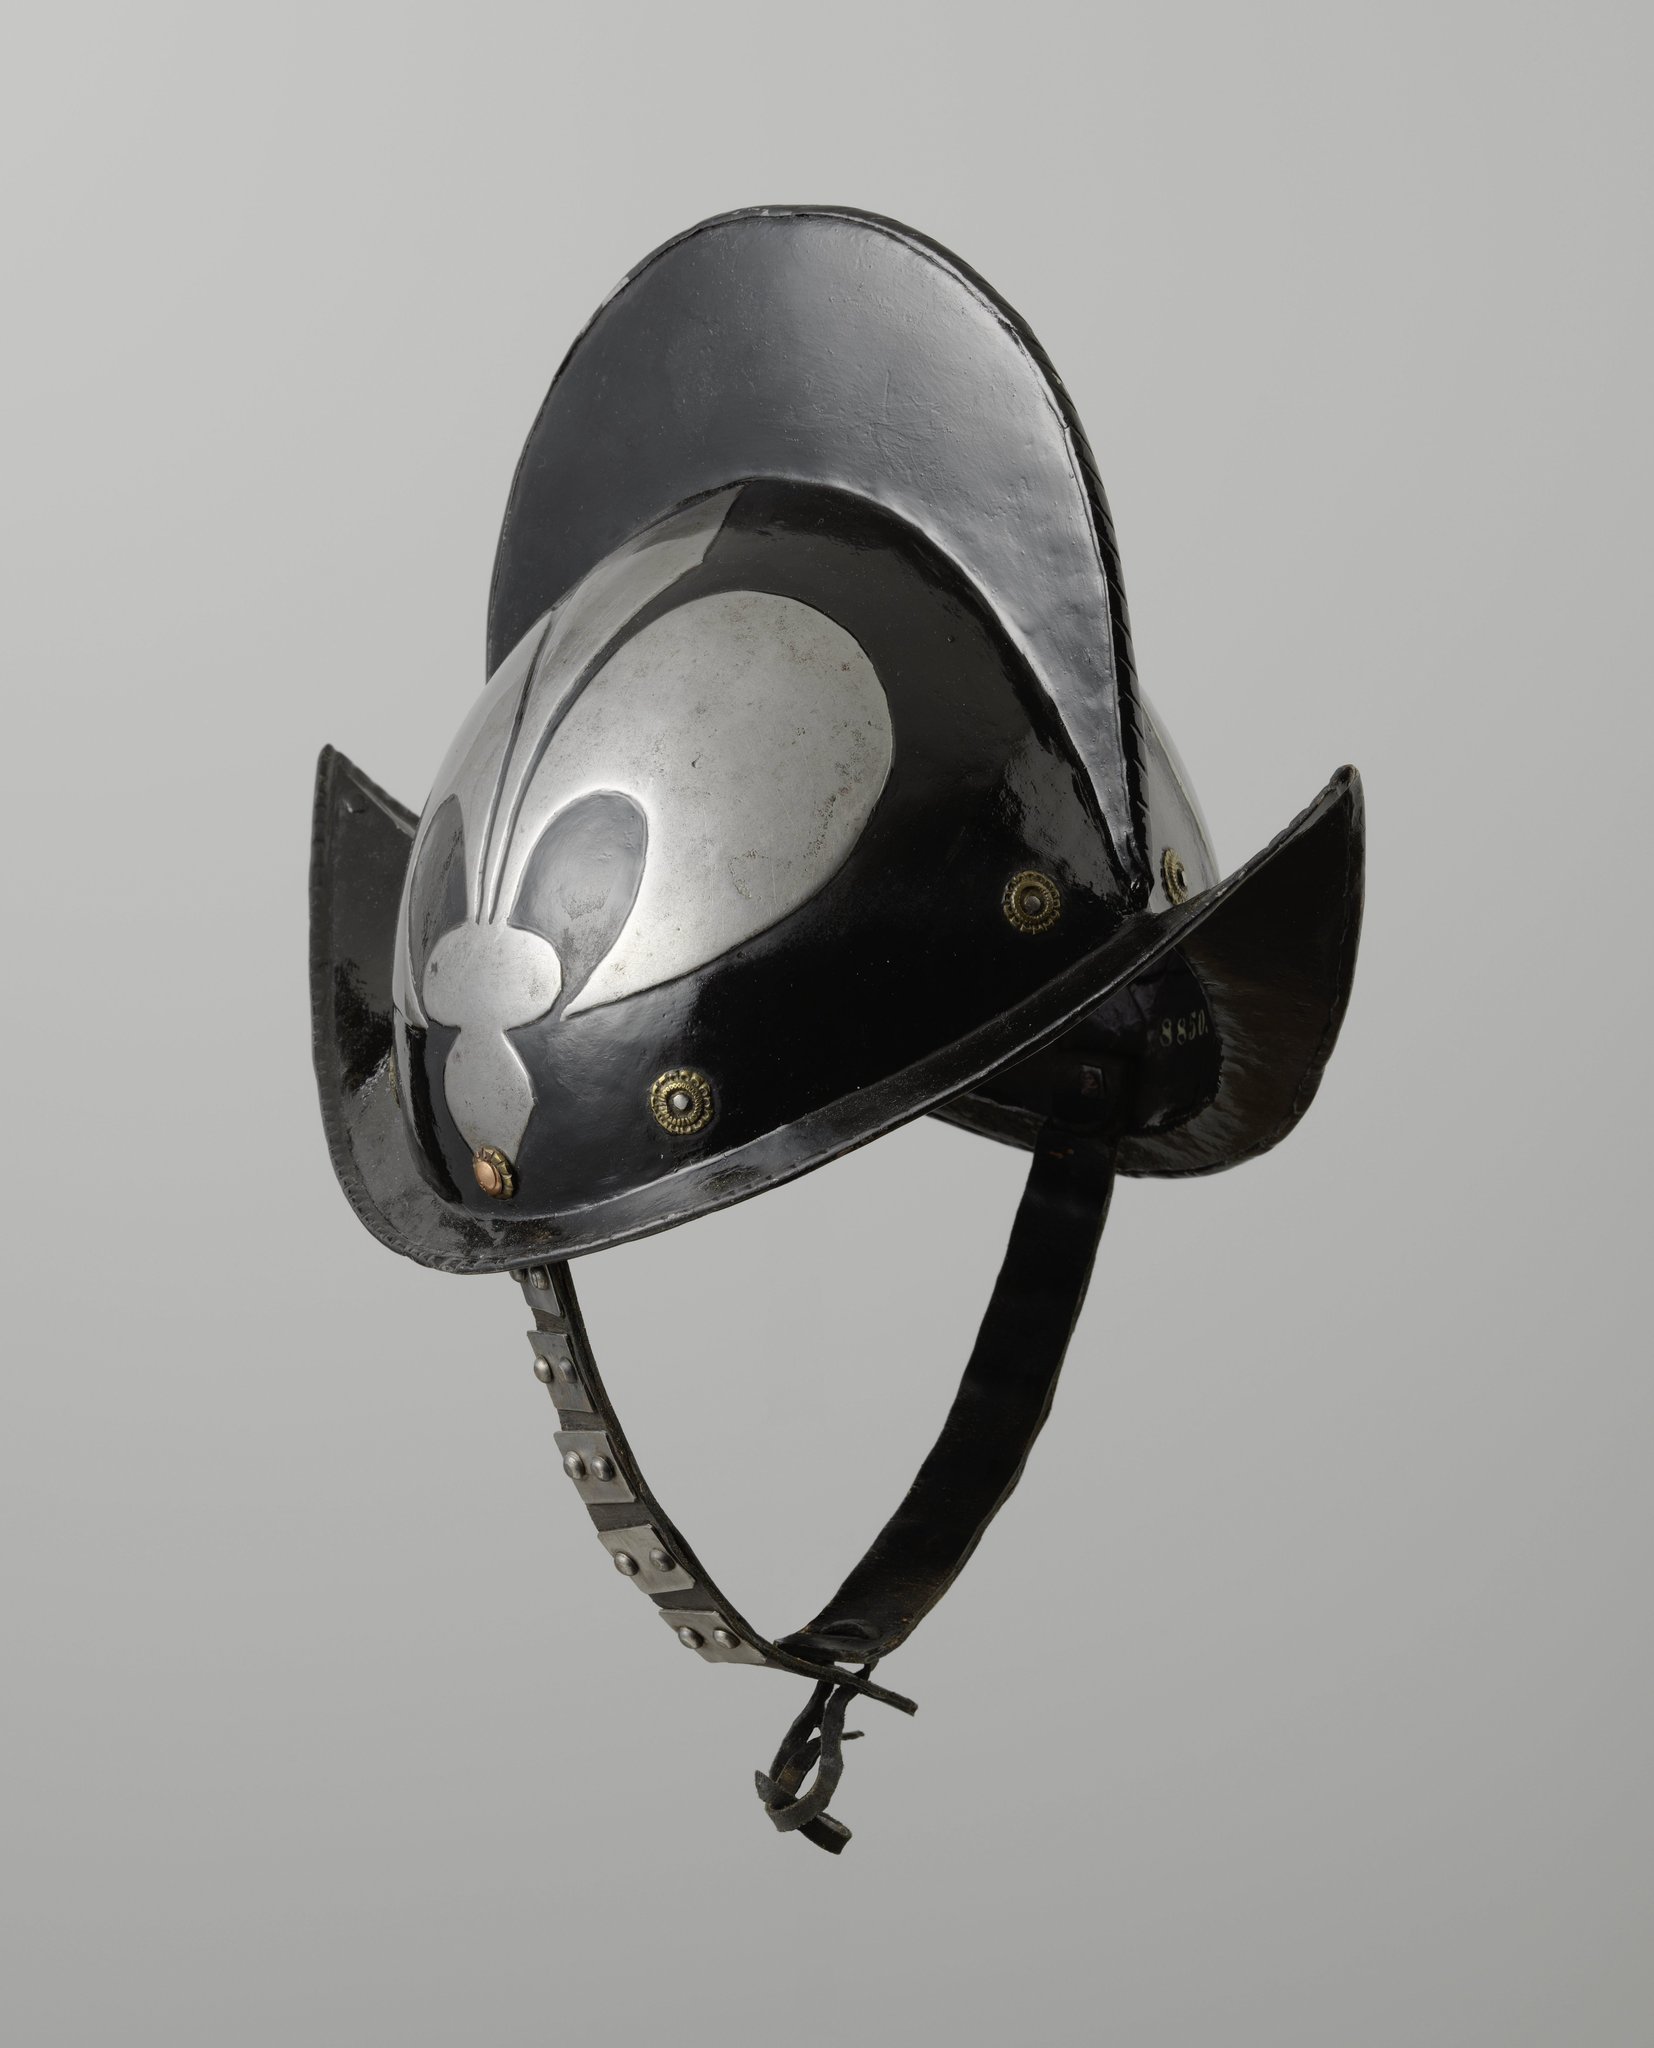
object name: morion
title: Morion-helm met uitgedreven lelie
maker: Anonymous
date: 1550-1600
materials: copper, iron, leather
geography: germany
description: Morion-helm, ijzer, gezwart met blank uitgedreven lelie, uit twee helften gemaakt. Hoge helmbol met hoge kam waarvan de rand gekabeld is. Rondom de basis van de helmbol acht geelkoperen rozetten. De klep heeft aan de voor- en achterzijde hoog oplopende punten. De rand van de klep is geflenst. Aan linker- en rechterzijde op de helmbol koperkleurige klinknagels waarmee de kinriem aan de binnenzijde is bevestigd. De leren kinriem bestaat uit twee leren banden waarvan de uiteinden aan elkaar bevestigd zijn. Iedere band heeft vijf metalen platen waar ieder twee klinknagels aan bevestigd zitten.